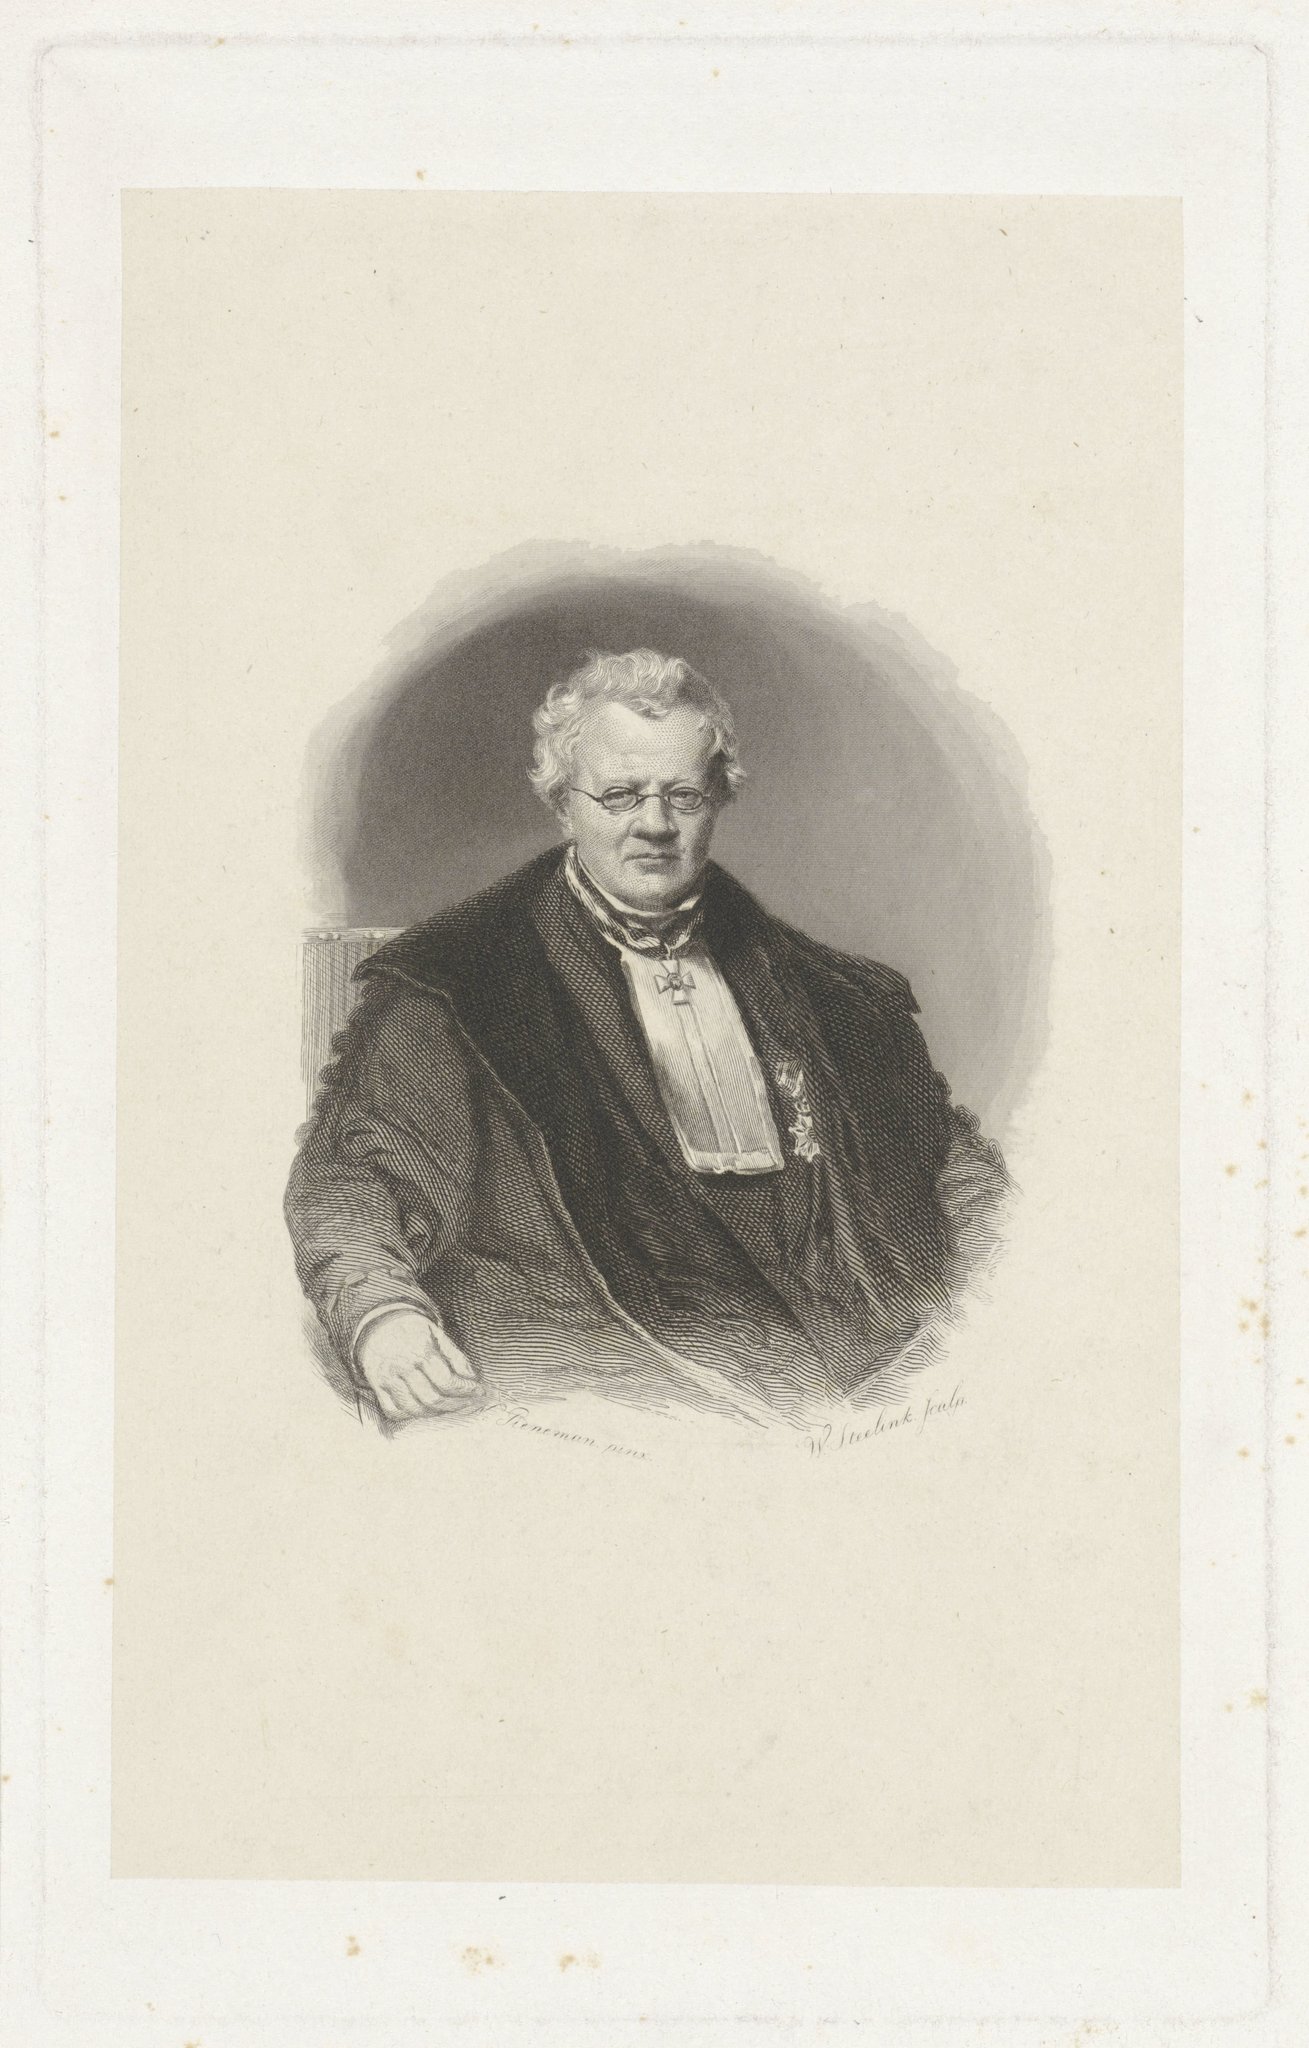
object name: print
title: Portret van Jacob van Hall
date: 1856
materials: paper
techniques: etching, engraving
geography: amsterdam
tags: rechtsgeleerde, jacob van hall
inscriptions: collector's mark: Lugt 2228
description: Portret van Jacob van Hall, rechtsgeleerde, gekleed in toga met witte bef.